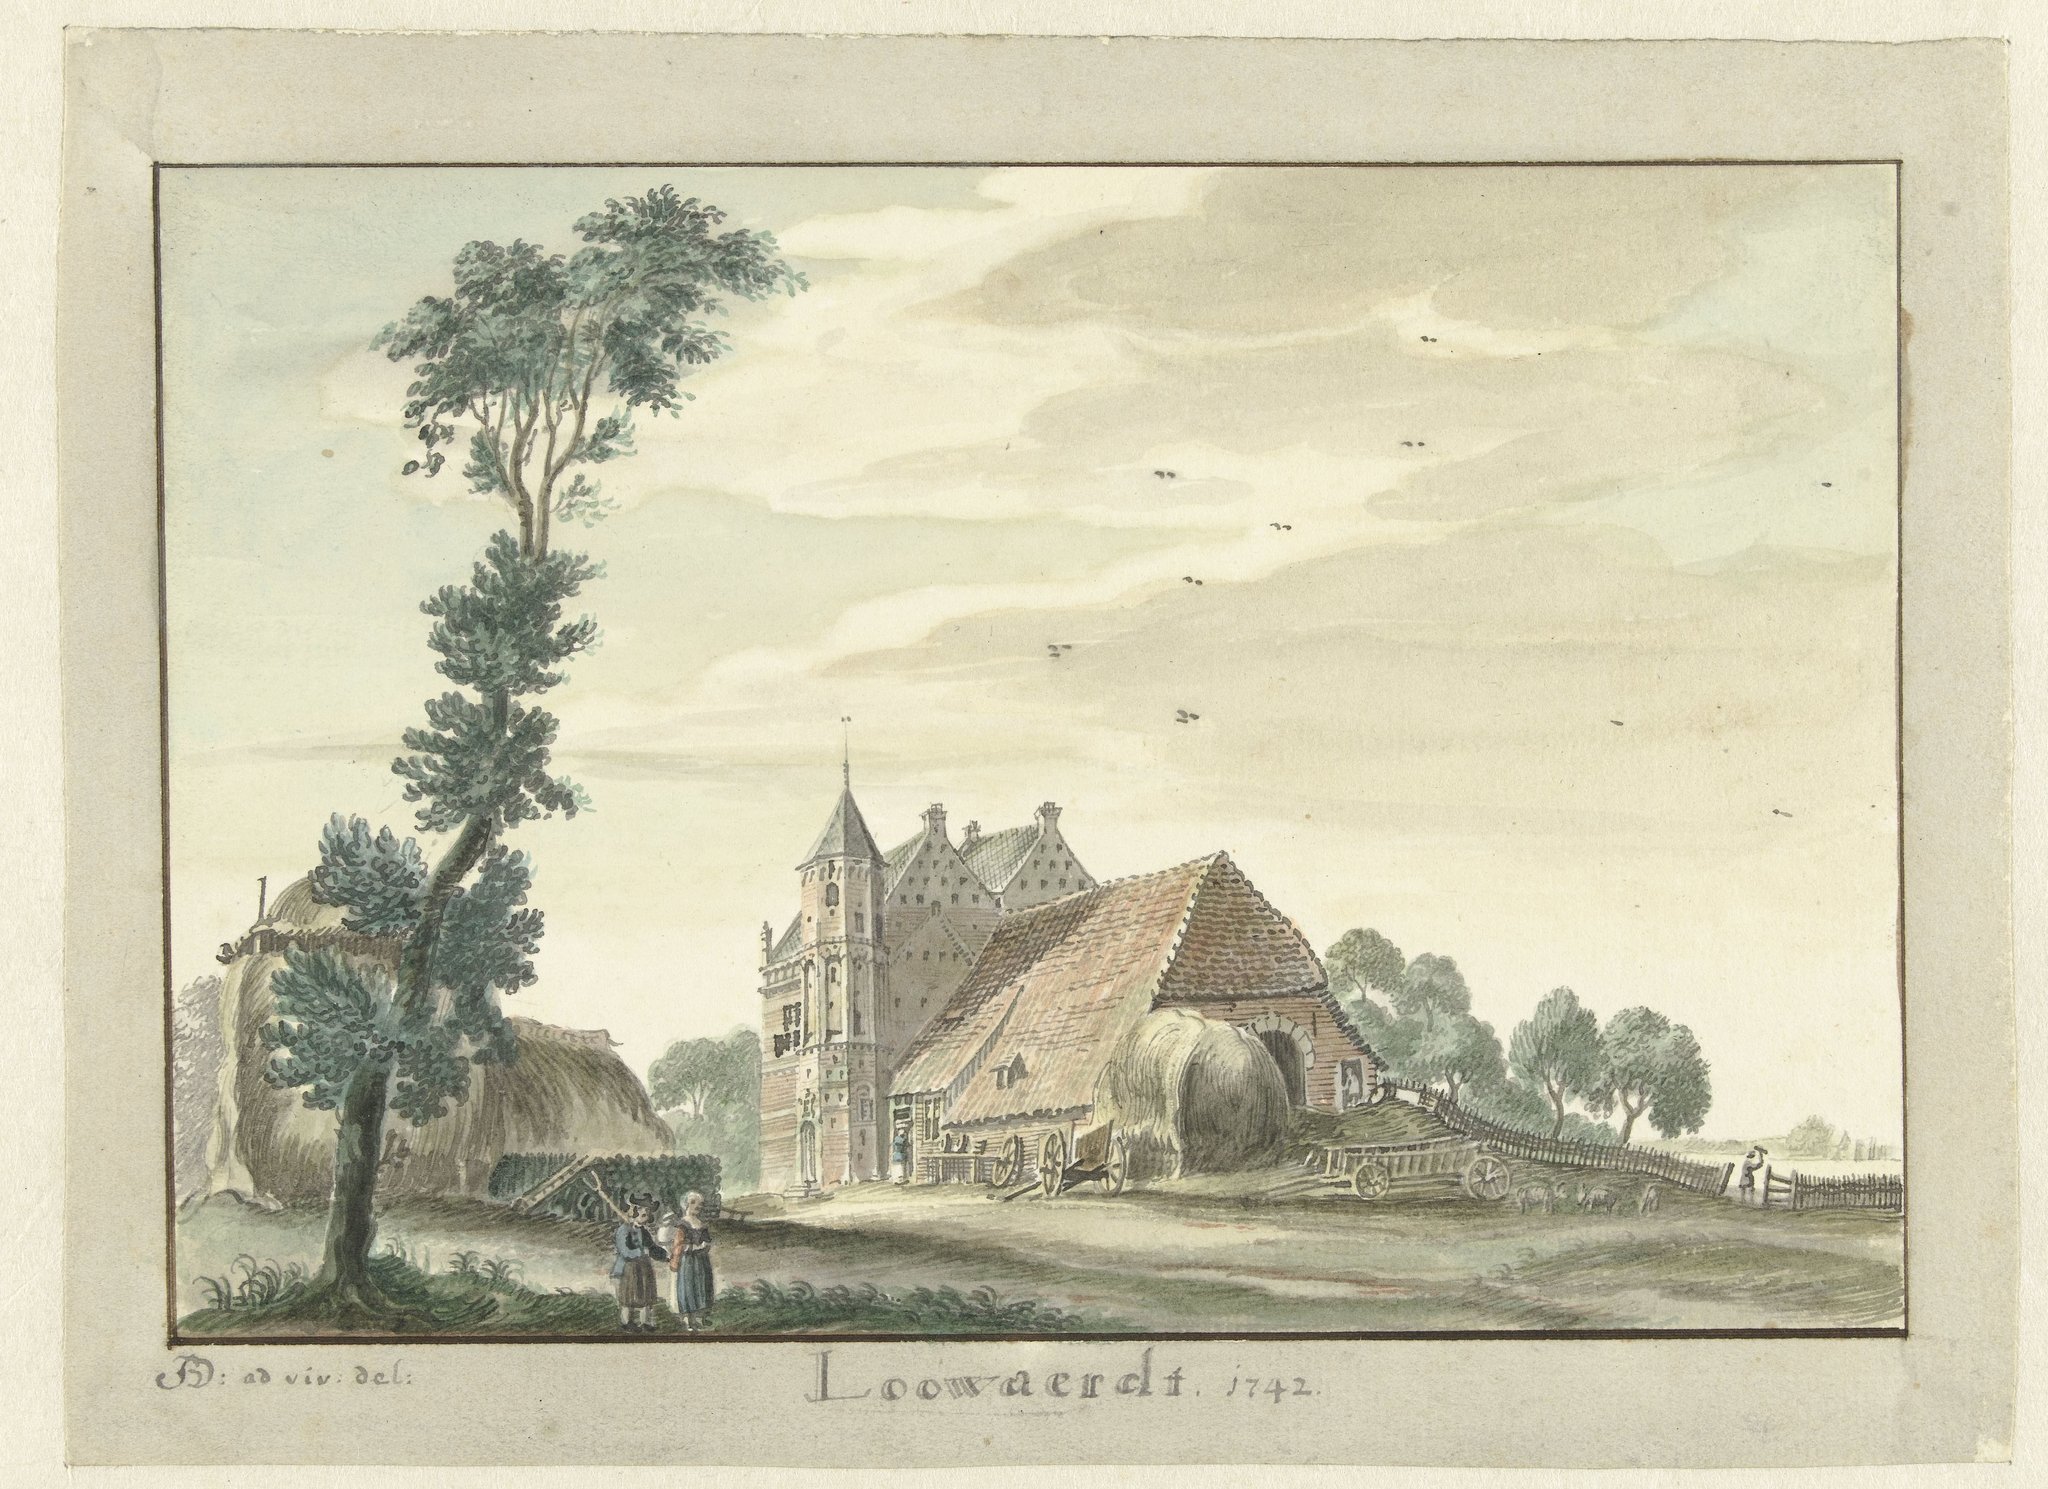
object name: watercolor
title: Loowaerdt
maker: jan de beijer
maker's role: draughtsman, print maker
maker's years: 1703-1780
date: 1742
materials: ink, paper, watercolor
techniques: brush, pen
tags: castle